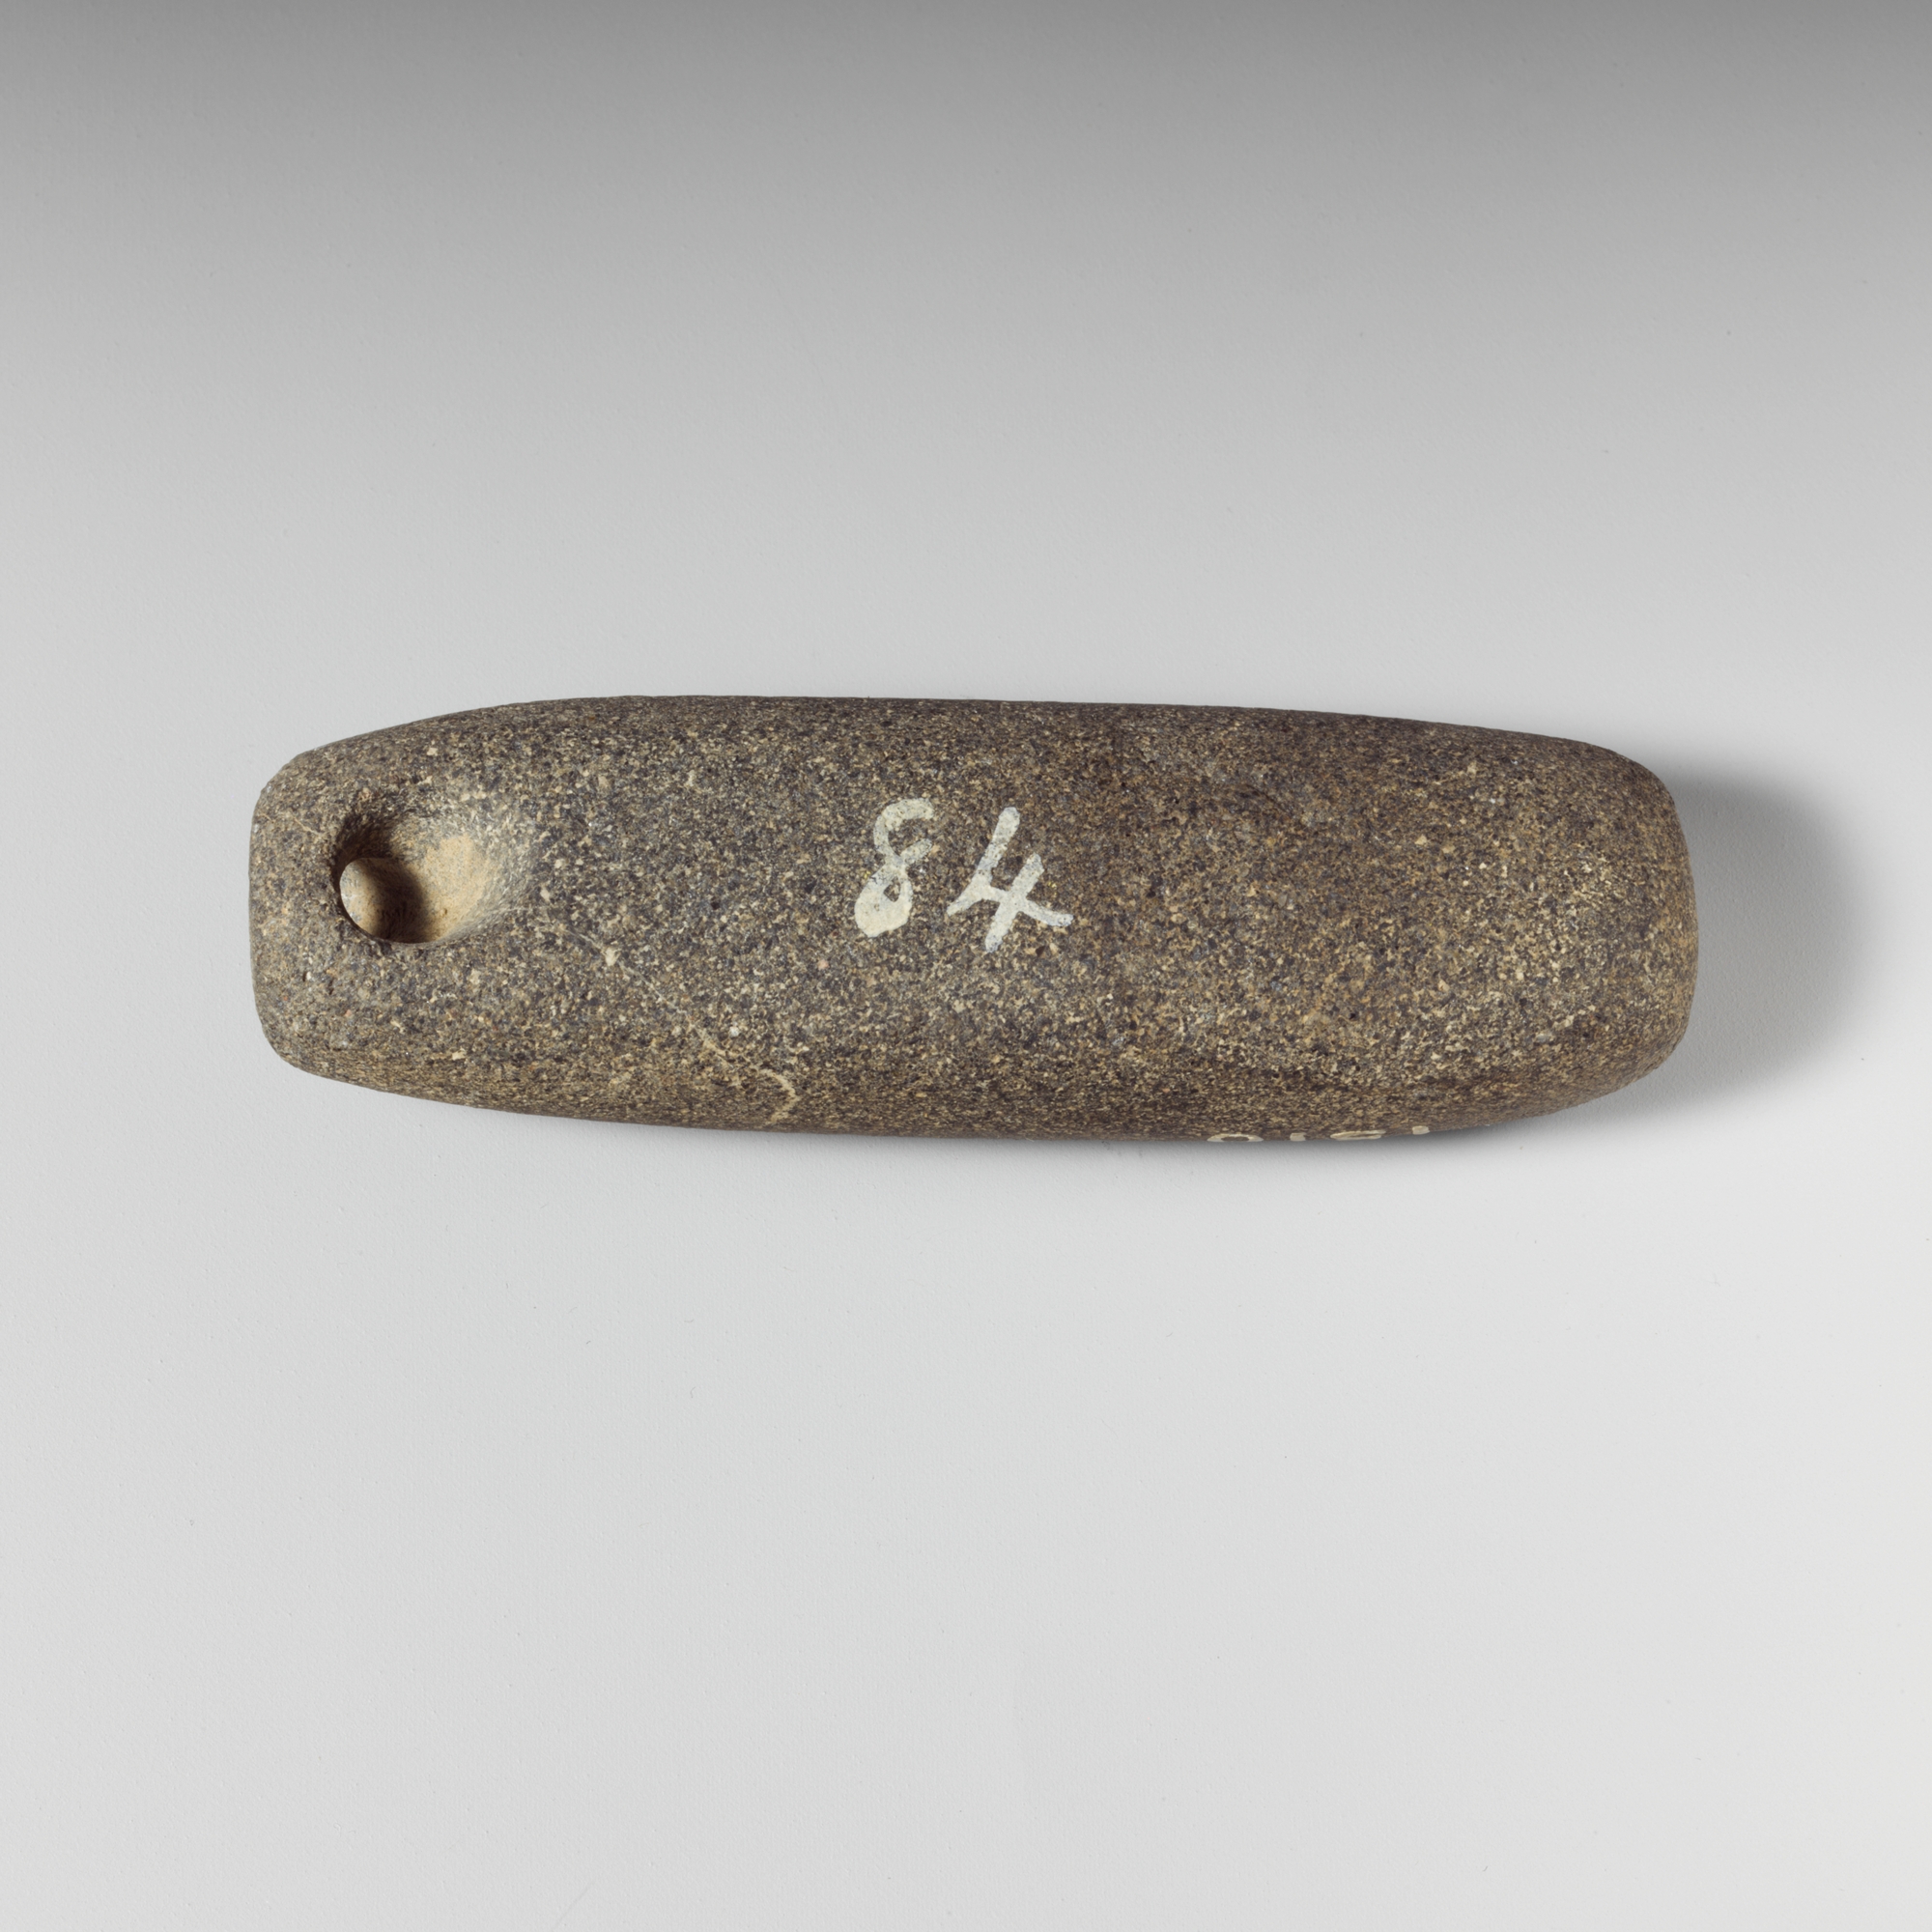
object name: polishing stone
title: Basalt whetstone or polisher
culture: cypriot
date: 3900 BCE-100 CE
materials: stone